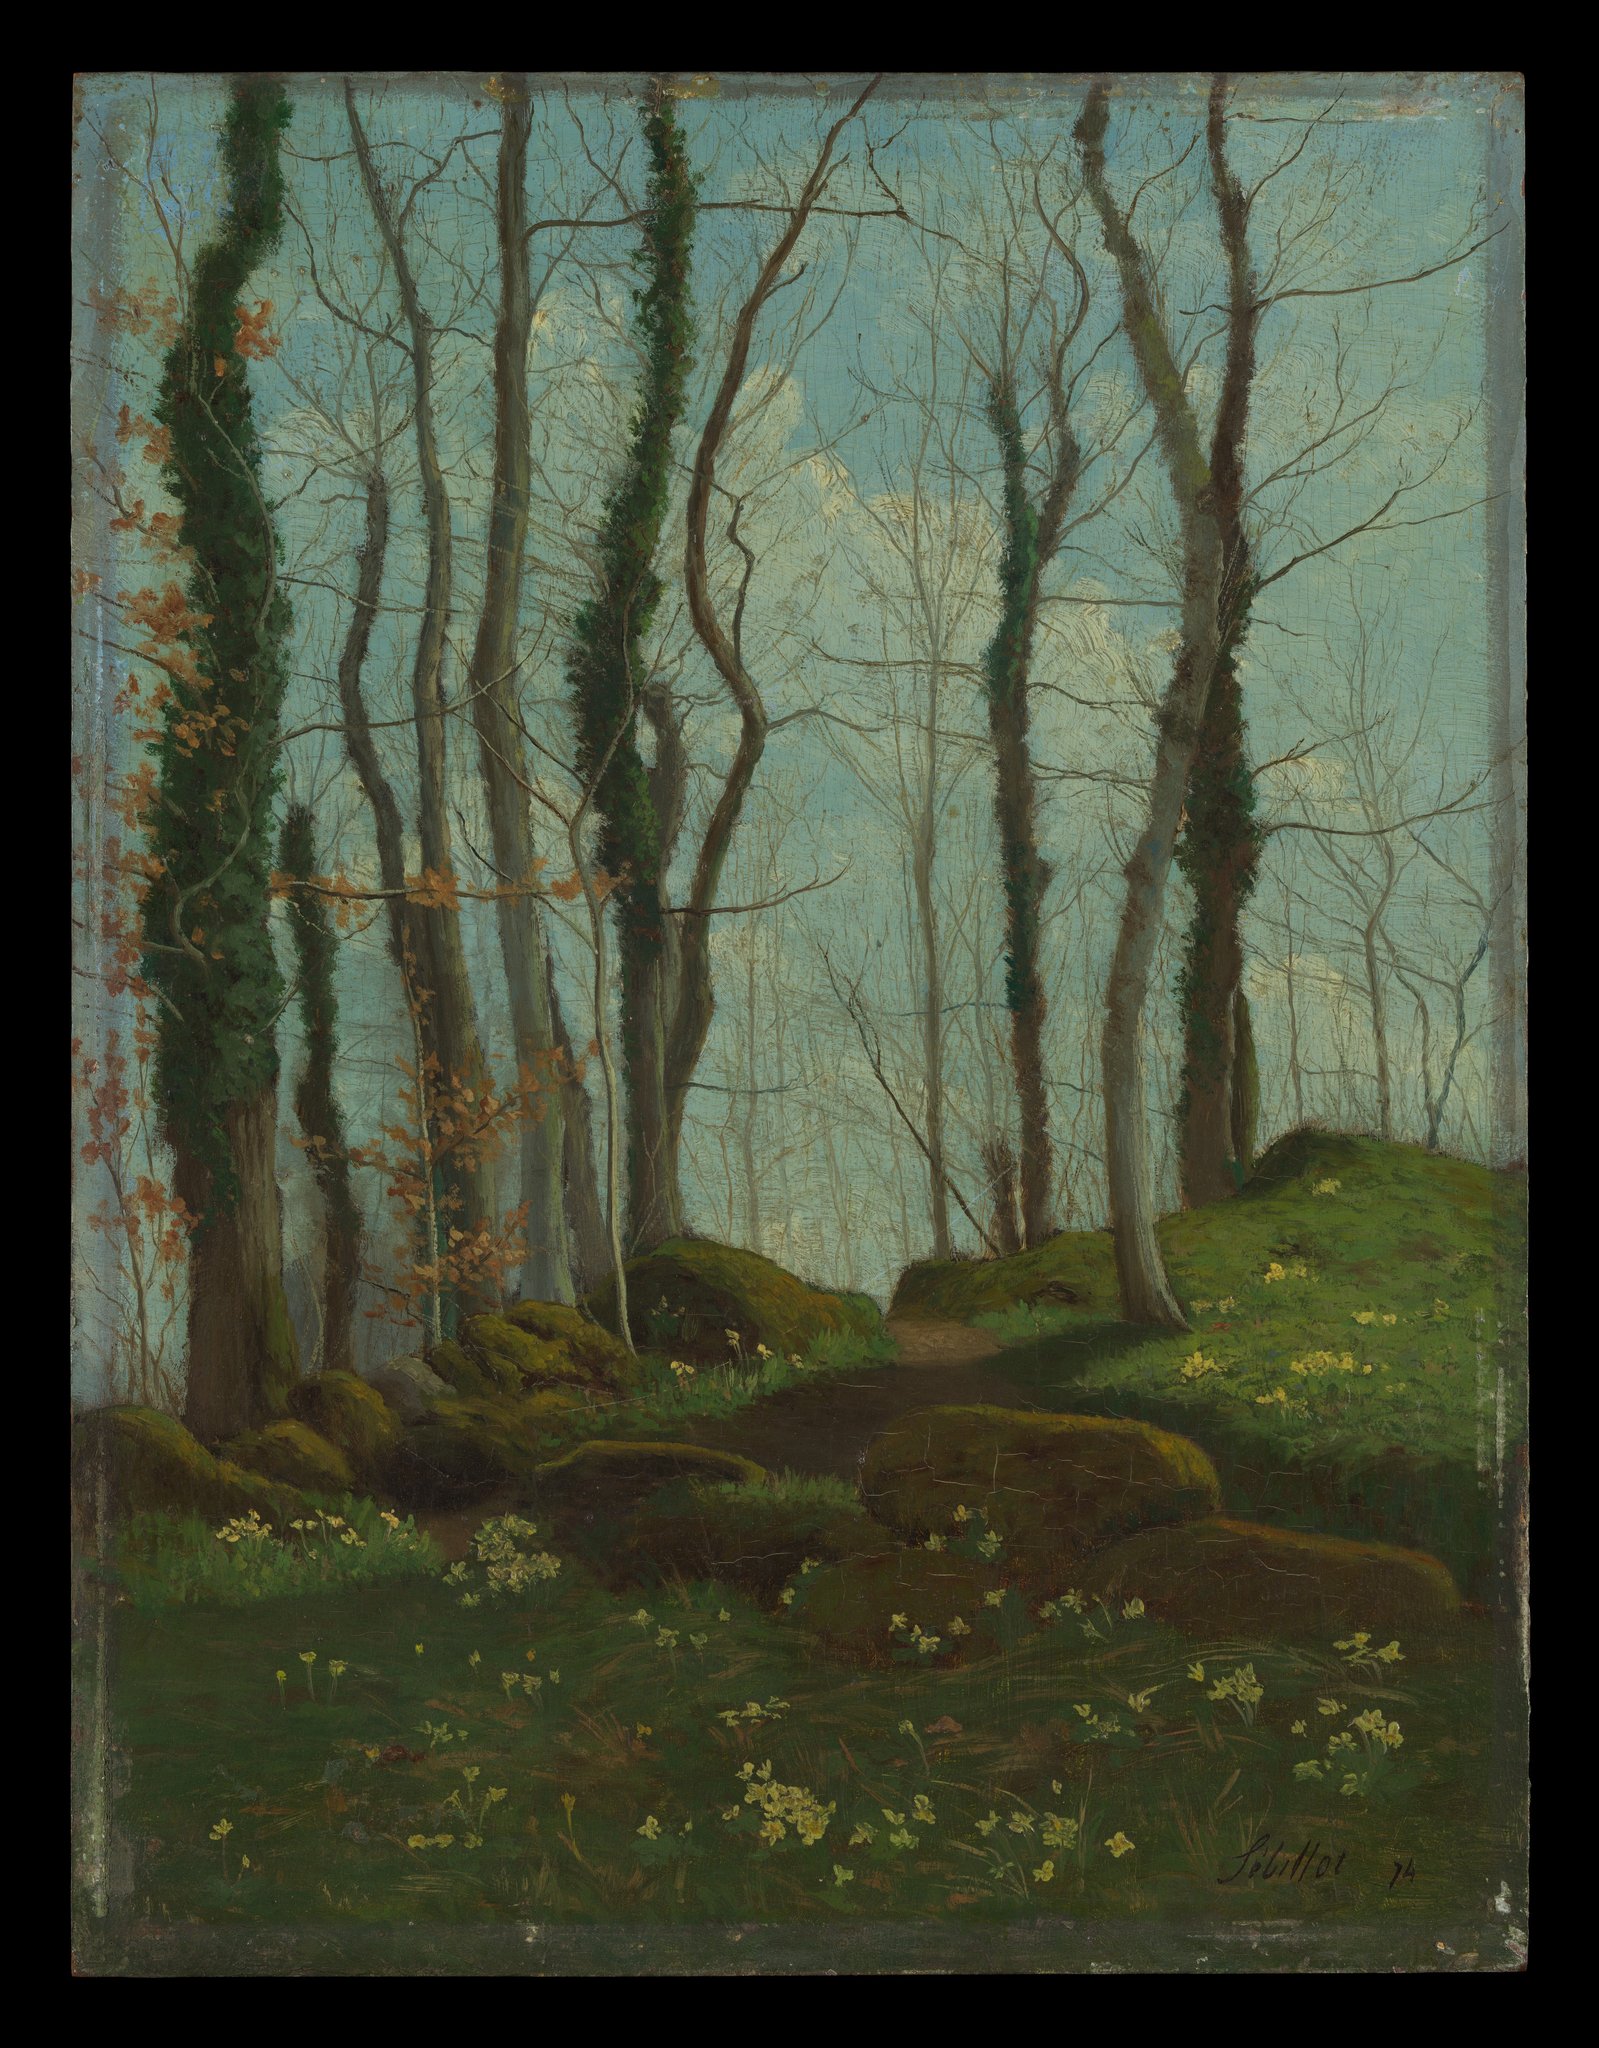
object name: painting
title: Spring in Brittany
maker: paul sébillot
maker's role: artist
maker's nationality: french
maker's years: 1843-1918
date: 1874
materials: oil, wood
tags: landscapes,spring